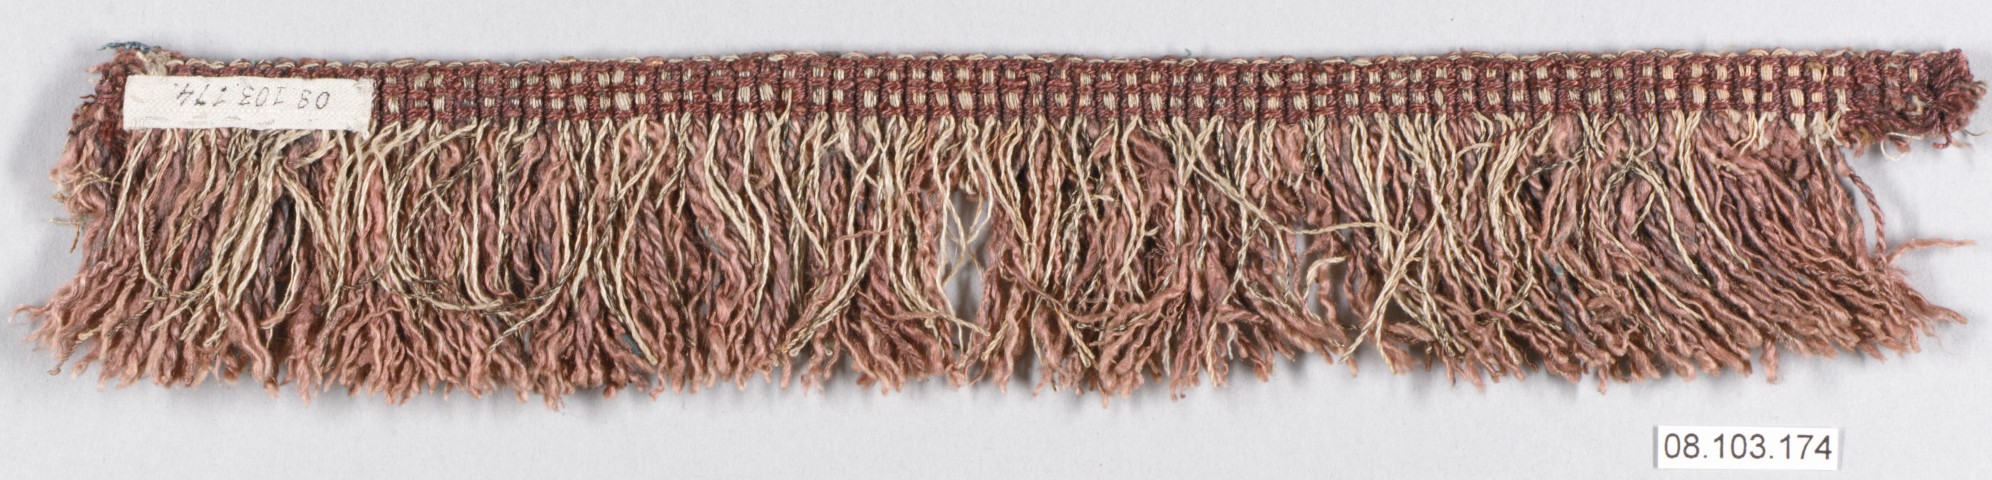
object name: fringe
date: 1701-1800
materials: cotton, metal thread